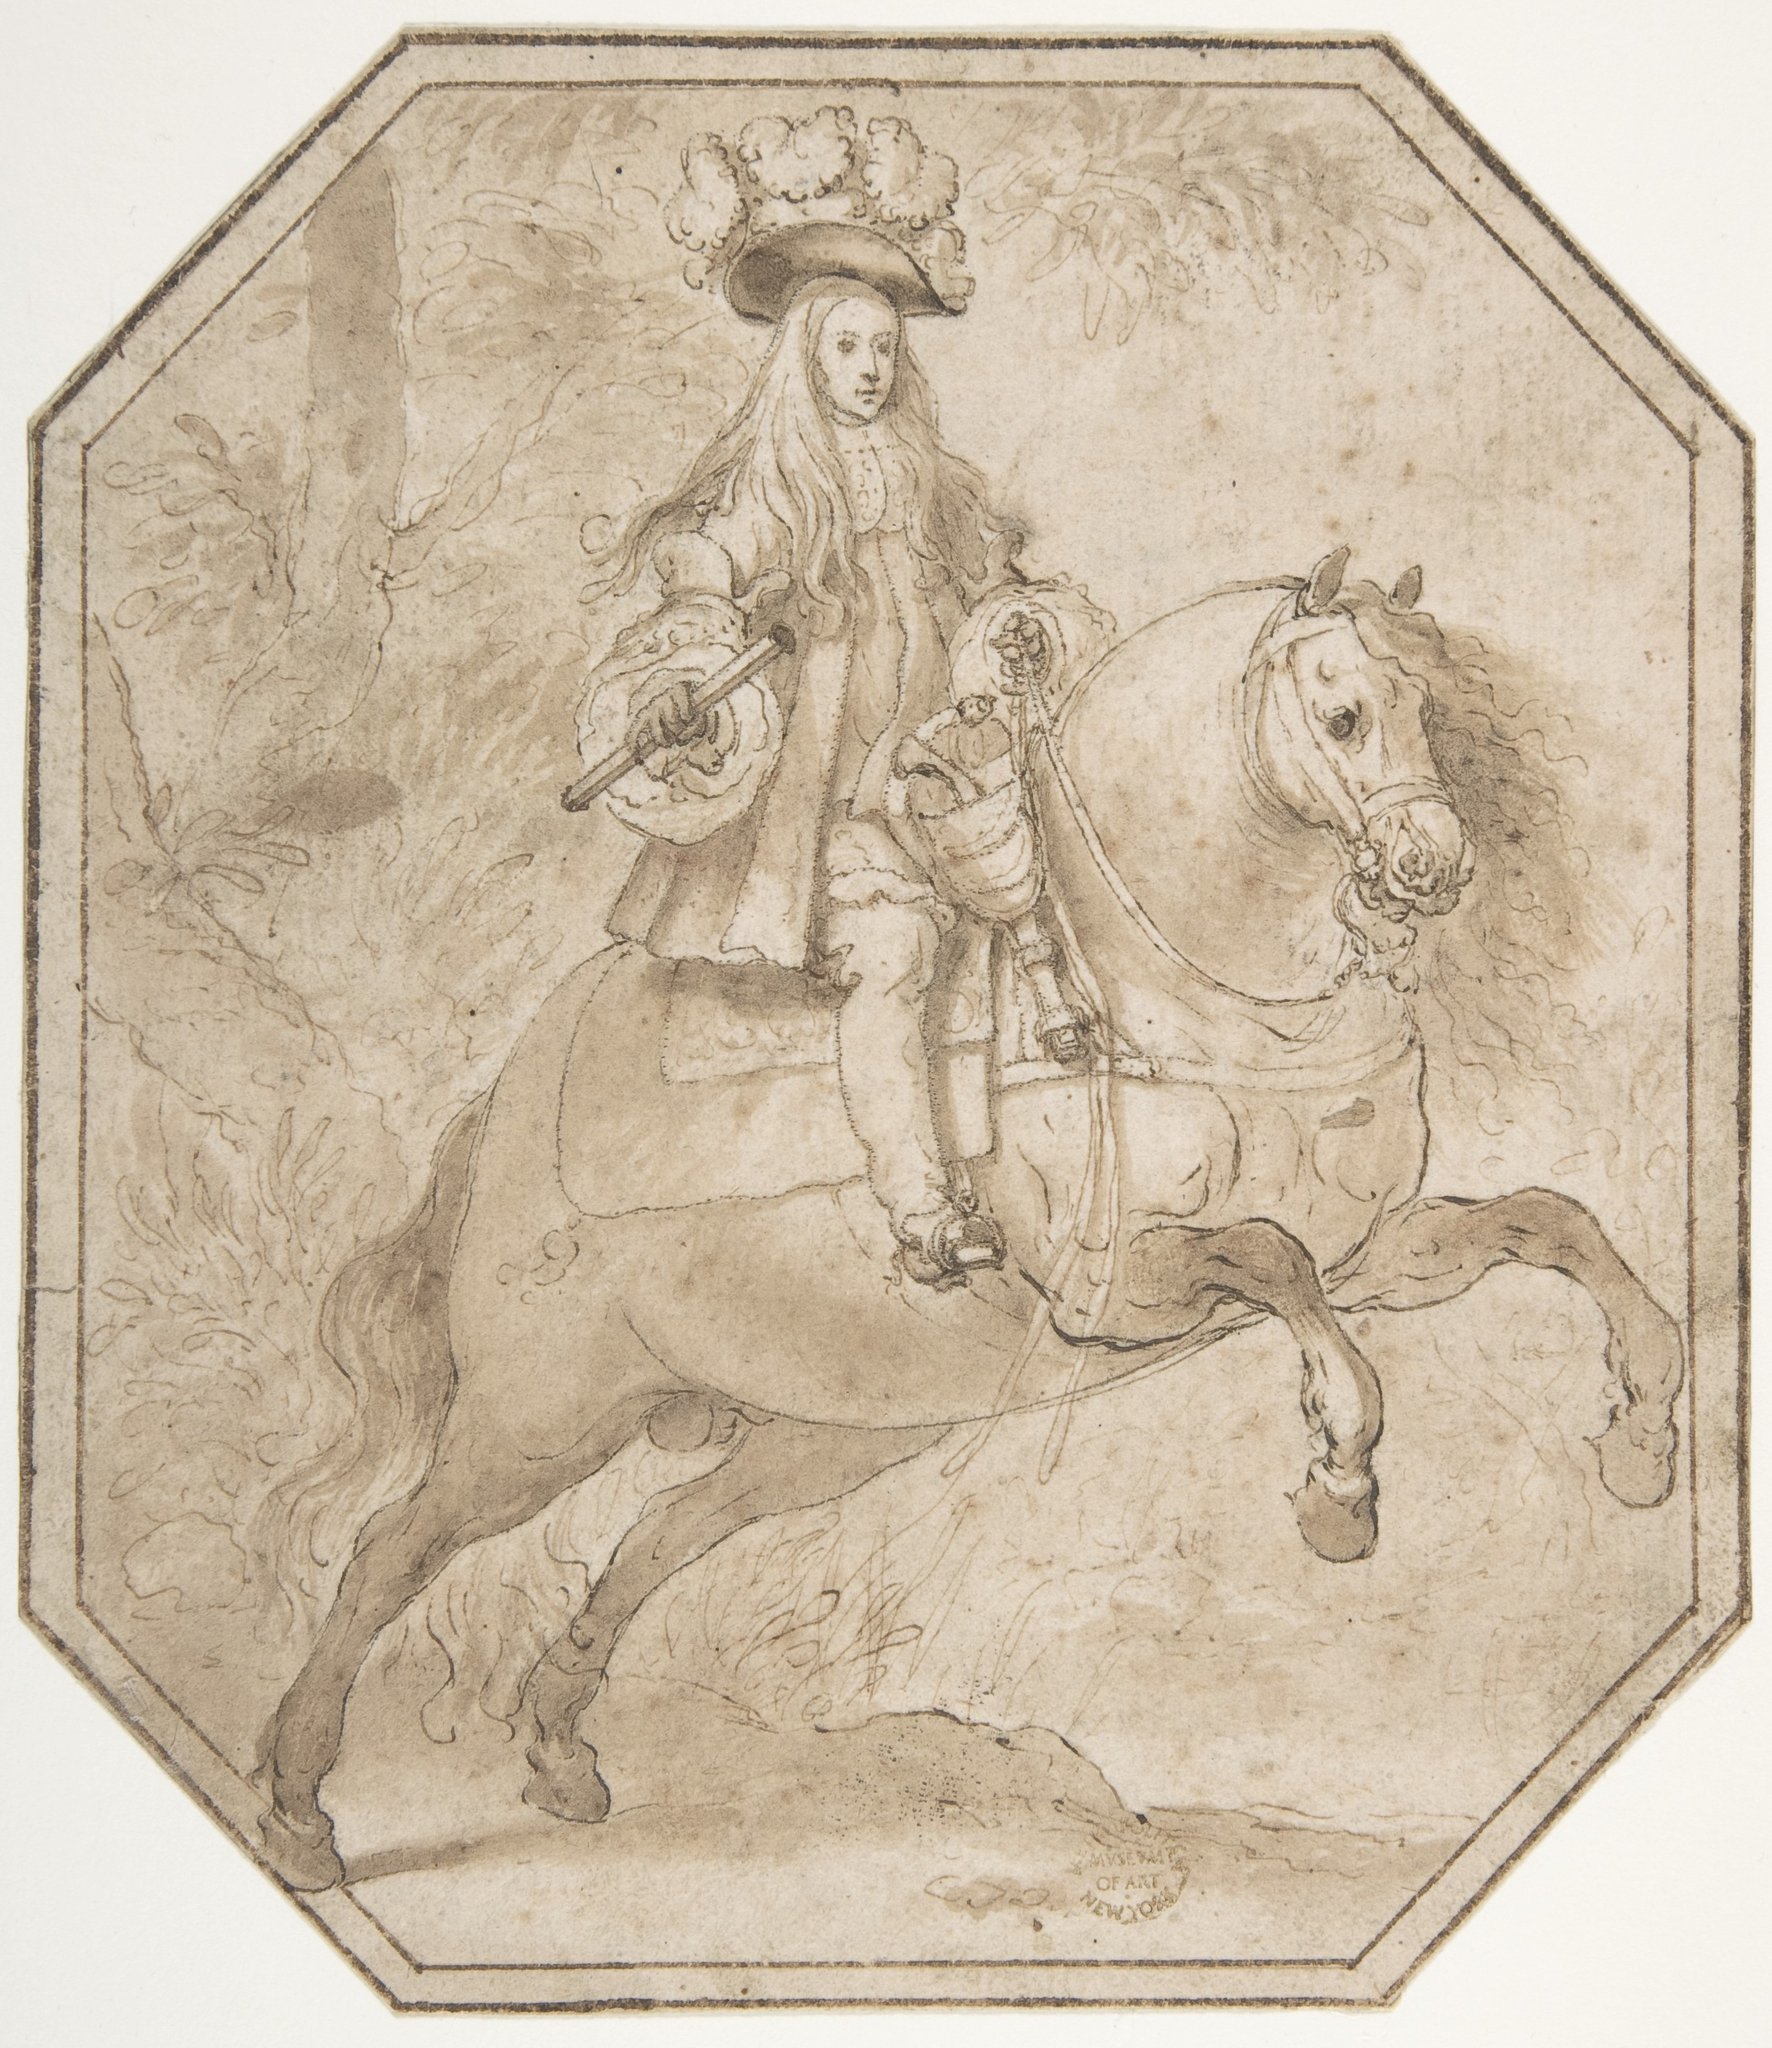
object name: drawing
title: Charles II of Spain on Horseback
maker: matías de torres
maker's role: artist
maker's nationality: spanish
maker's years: 1635-1711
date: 1667-1700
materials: chalk, ink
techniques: brush, cutting, pen, drawing, wash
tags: men,horses